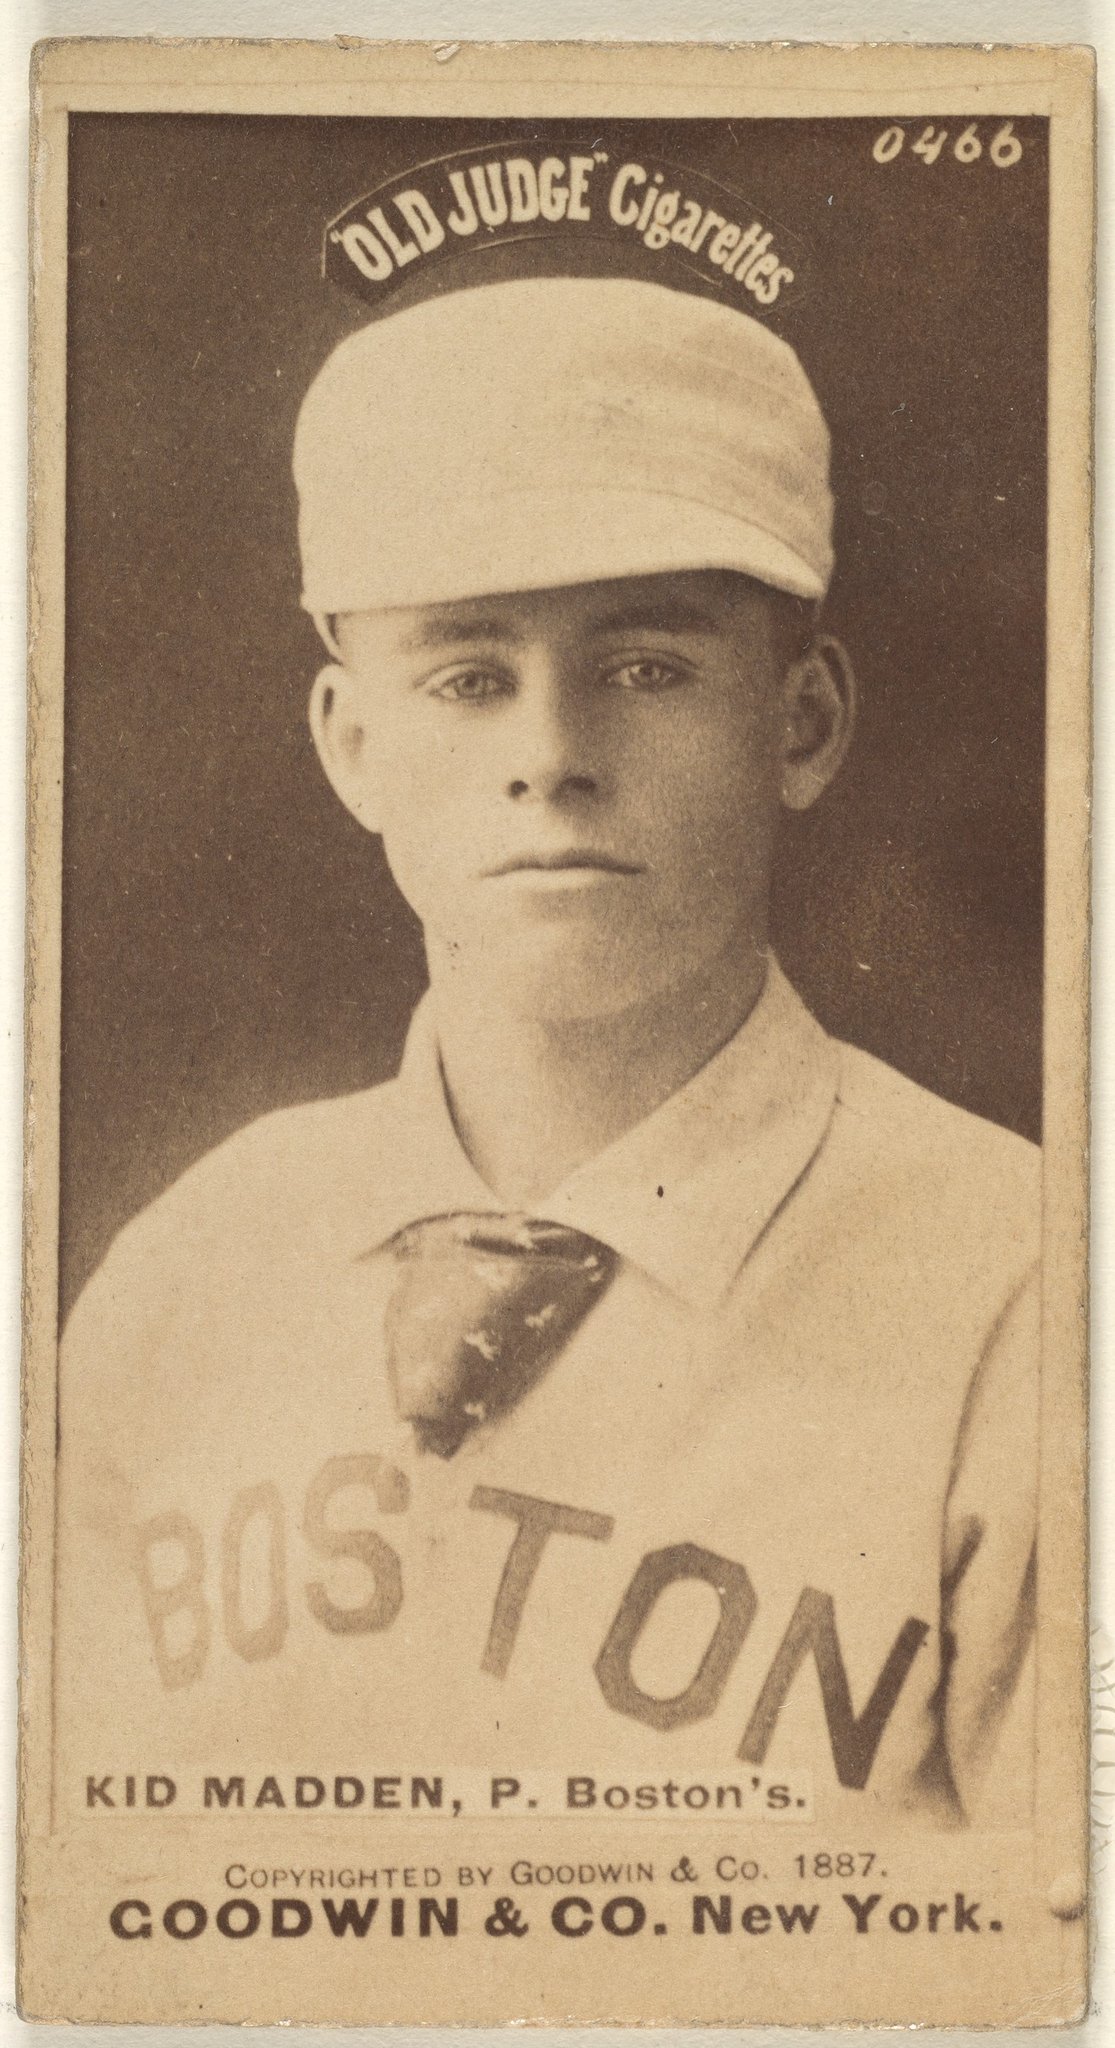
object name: baseball card, photograph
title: Kid Madden, Pitcher, Boston, from the Old Judge series (N172) for Old Judge Cigarettes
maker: goodwin & company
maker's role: publisher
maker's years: 1850-1950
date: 1887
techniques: albumen silver print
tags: men,portraits,baseball,athletes